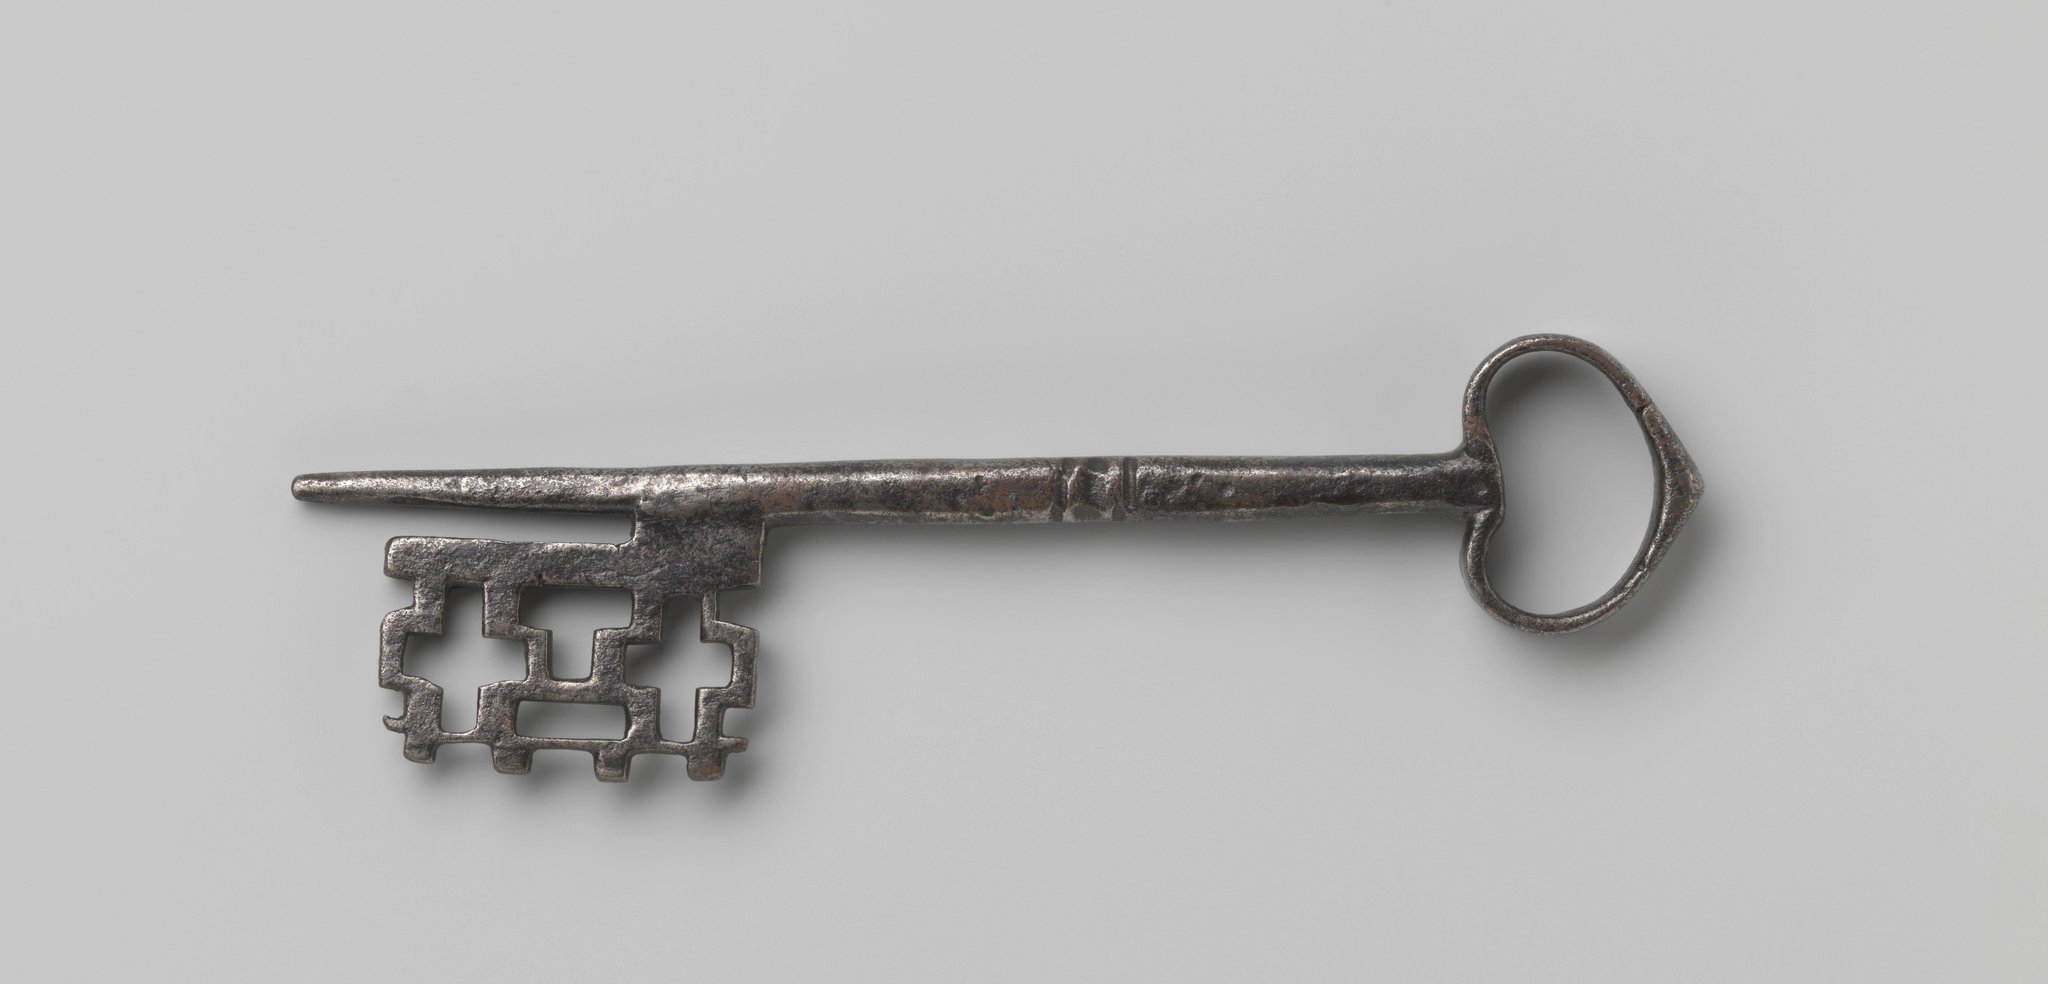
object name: key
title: Sleutel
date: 1400-1500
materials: iron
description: Sleutel met boonvormig oog, boven enigszins zich toespitsend. De schacht heeft in het midden drie inkepingen en loopt onder de baard in een punt uit. In de baard zijn twee liggende kruizen uitgehakt.